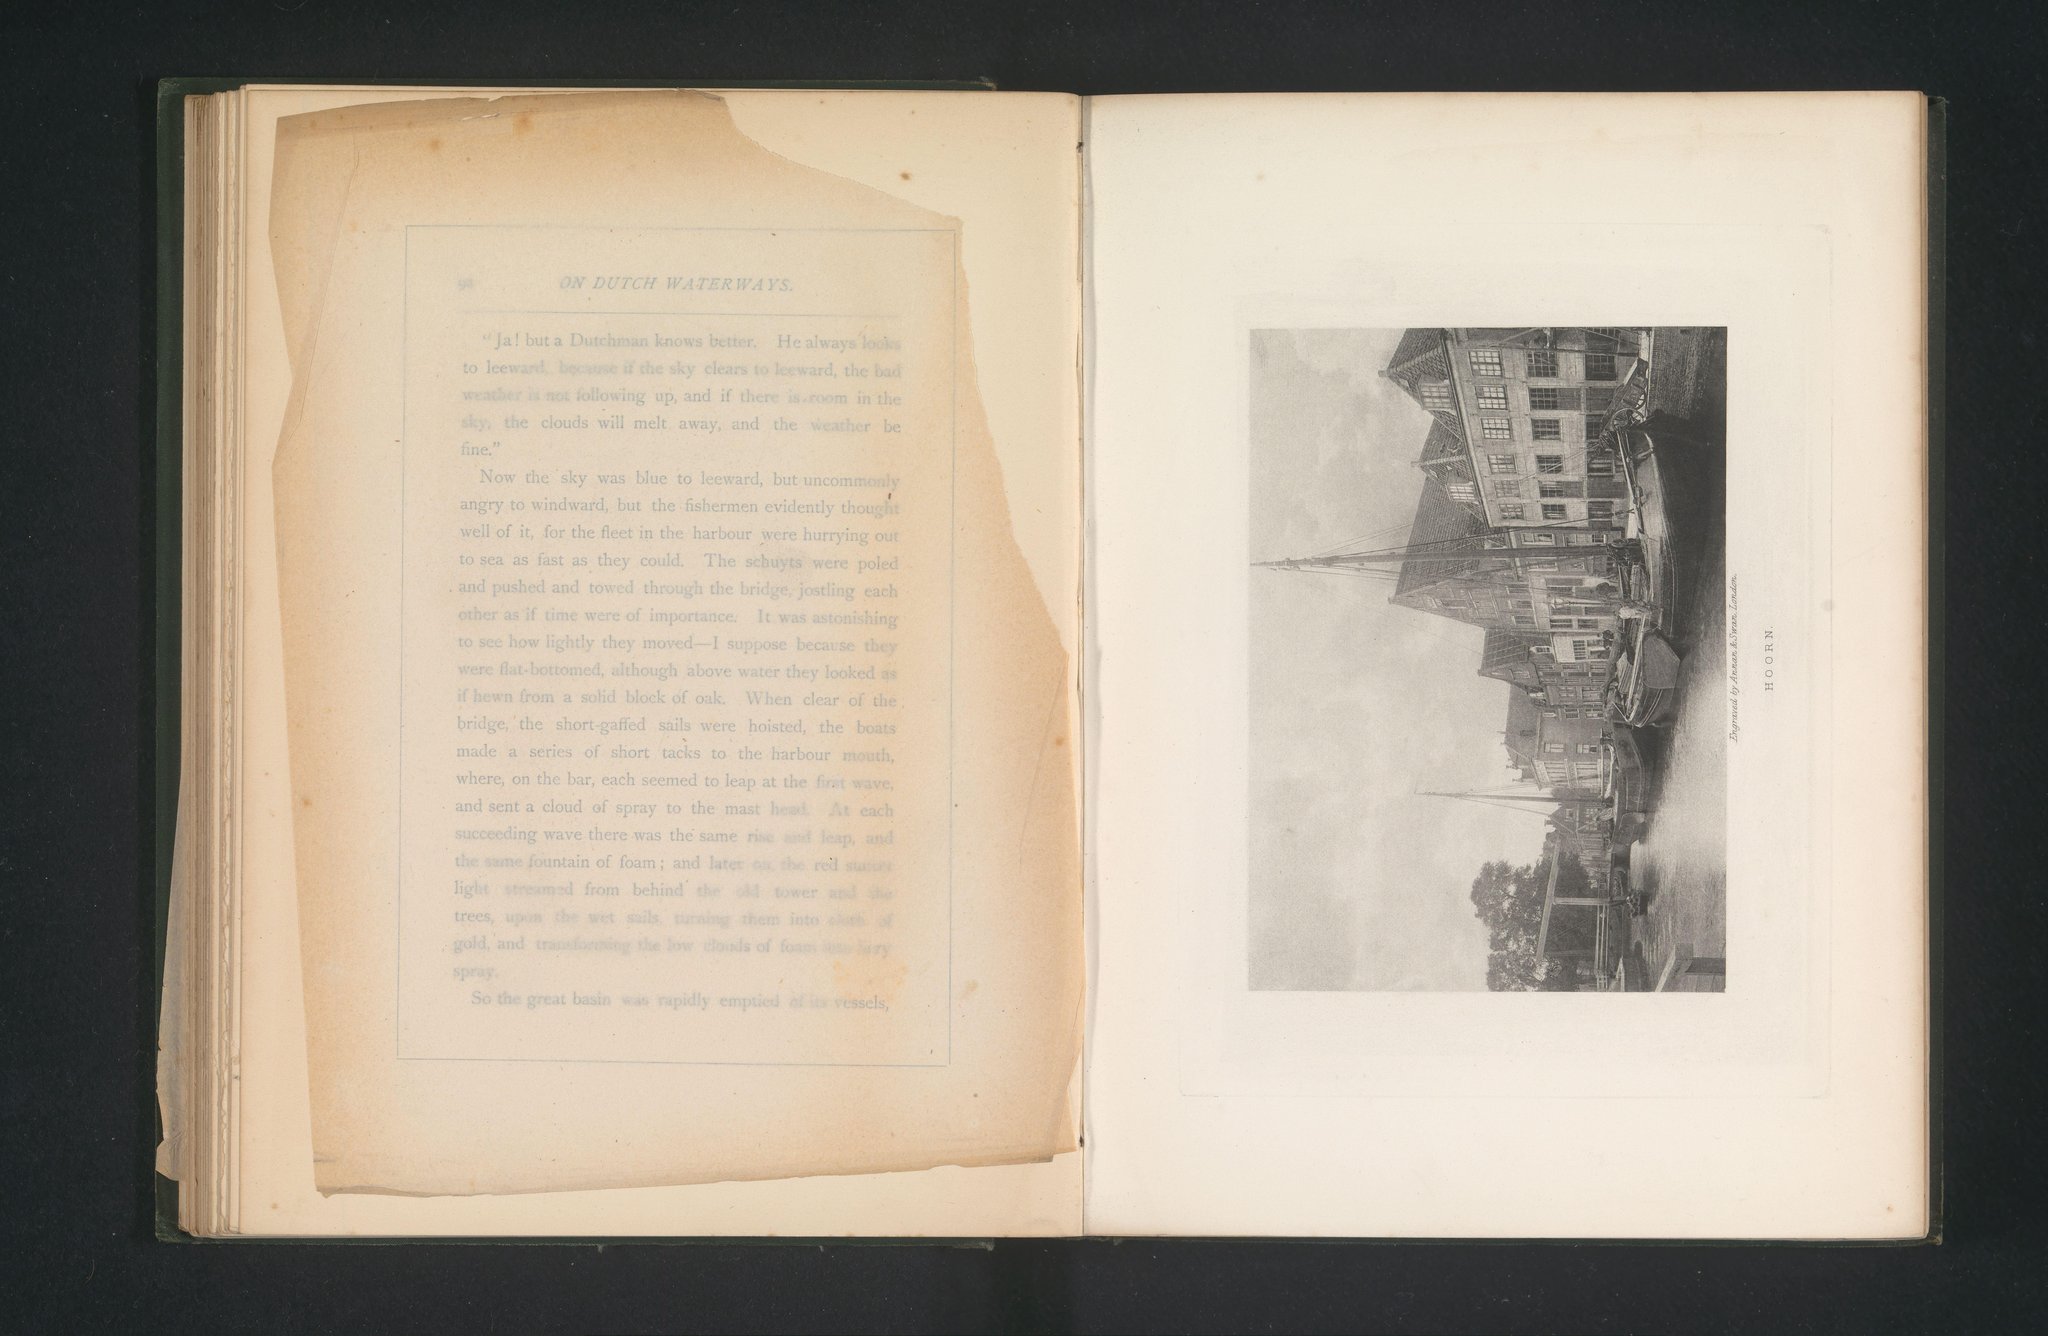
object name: page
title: Hoorn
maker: george christopher davies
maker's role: fotograaf, geoloog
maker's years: 1849-1922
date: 1881-1886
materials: paper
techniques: photoaquatint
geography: hoorn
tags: harbour, sailing-ship, sailing-boat, hoorn (north holland)